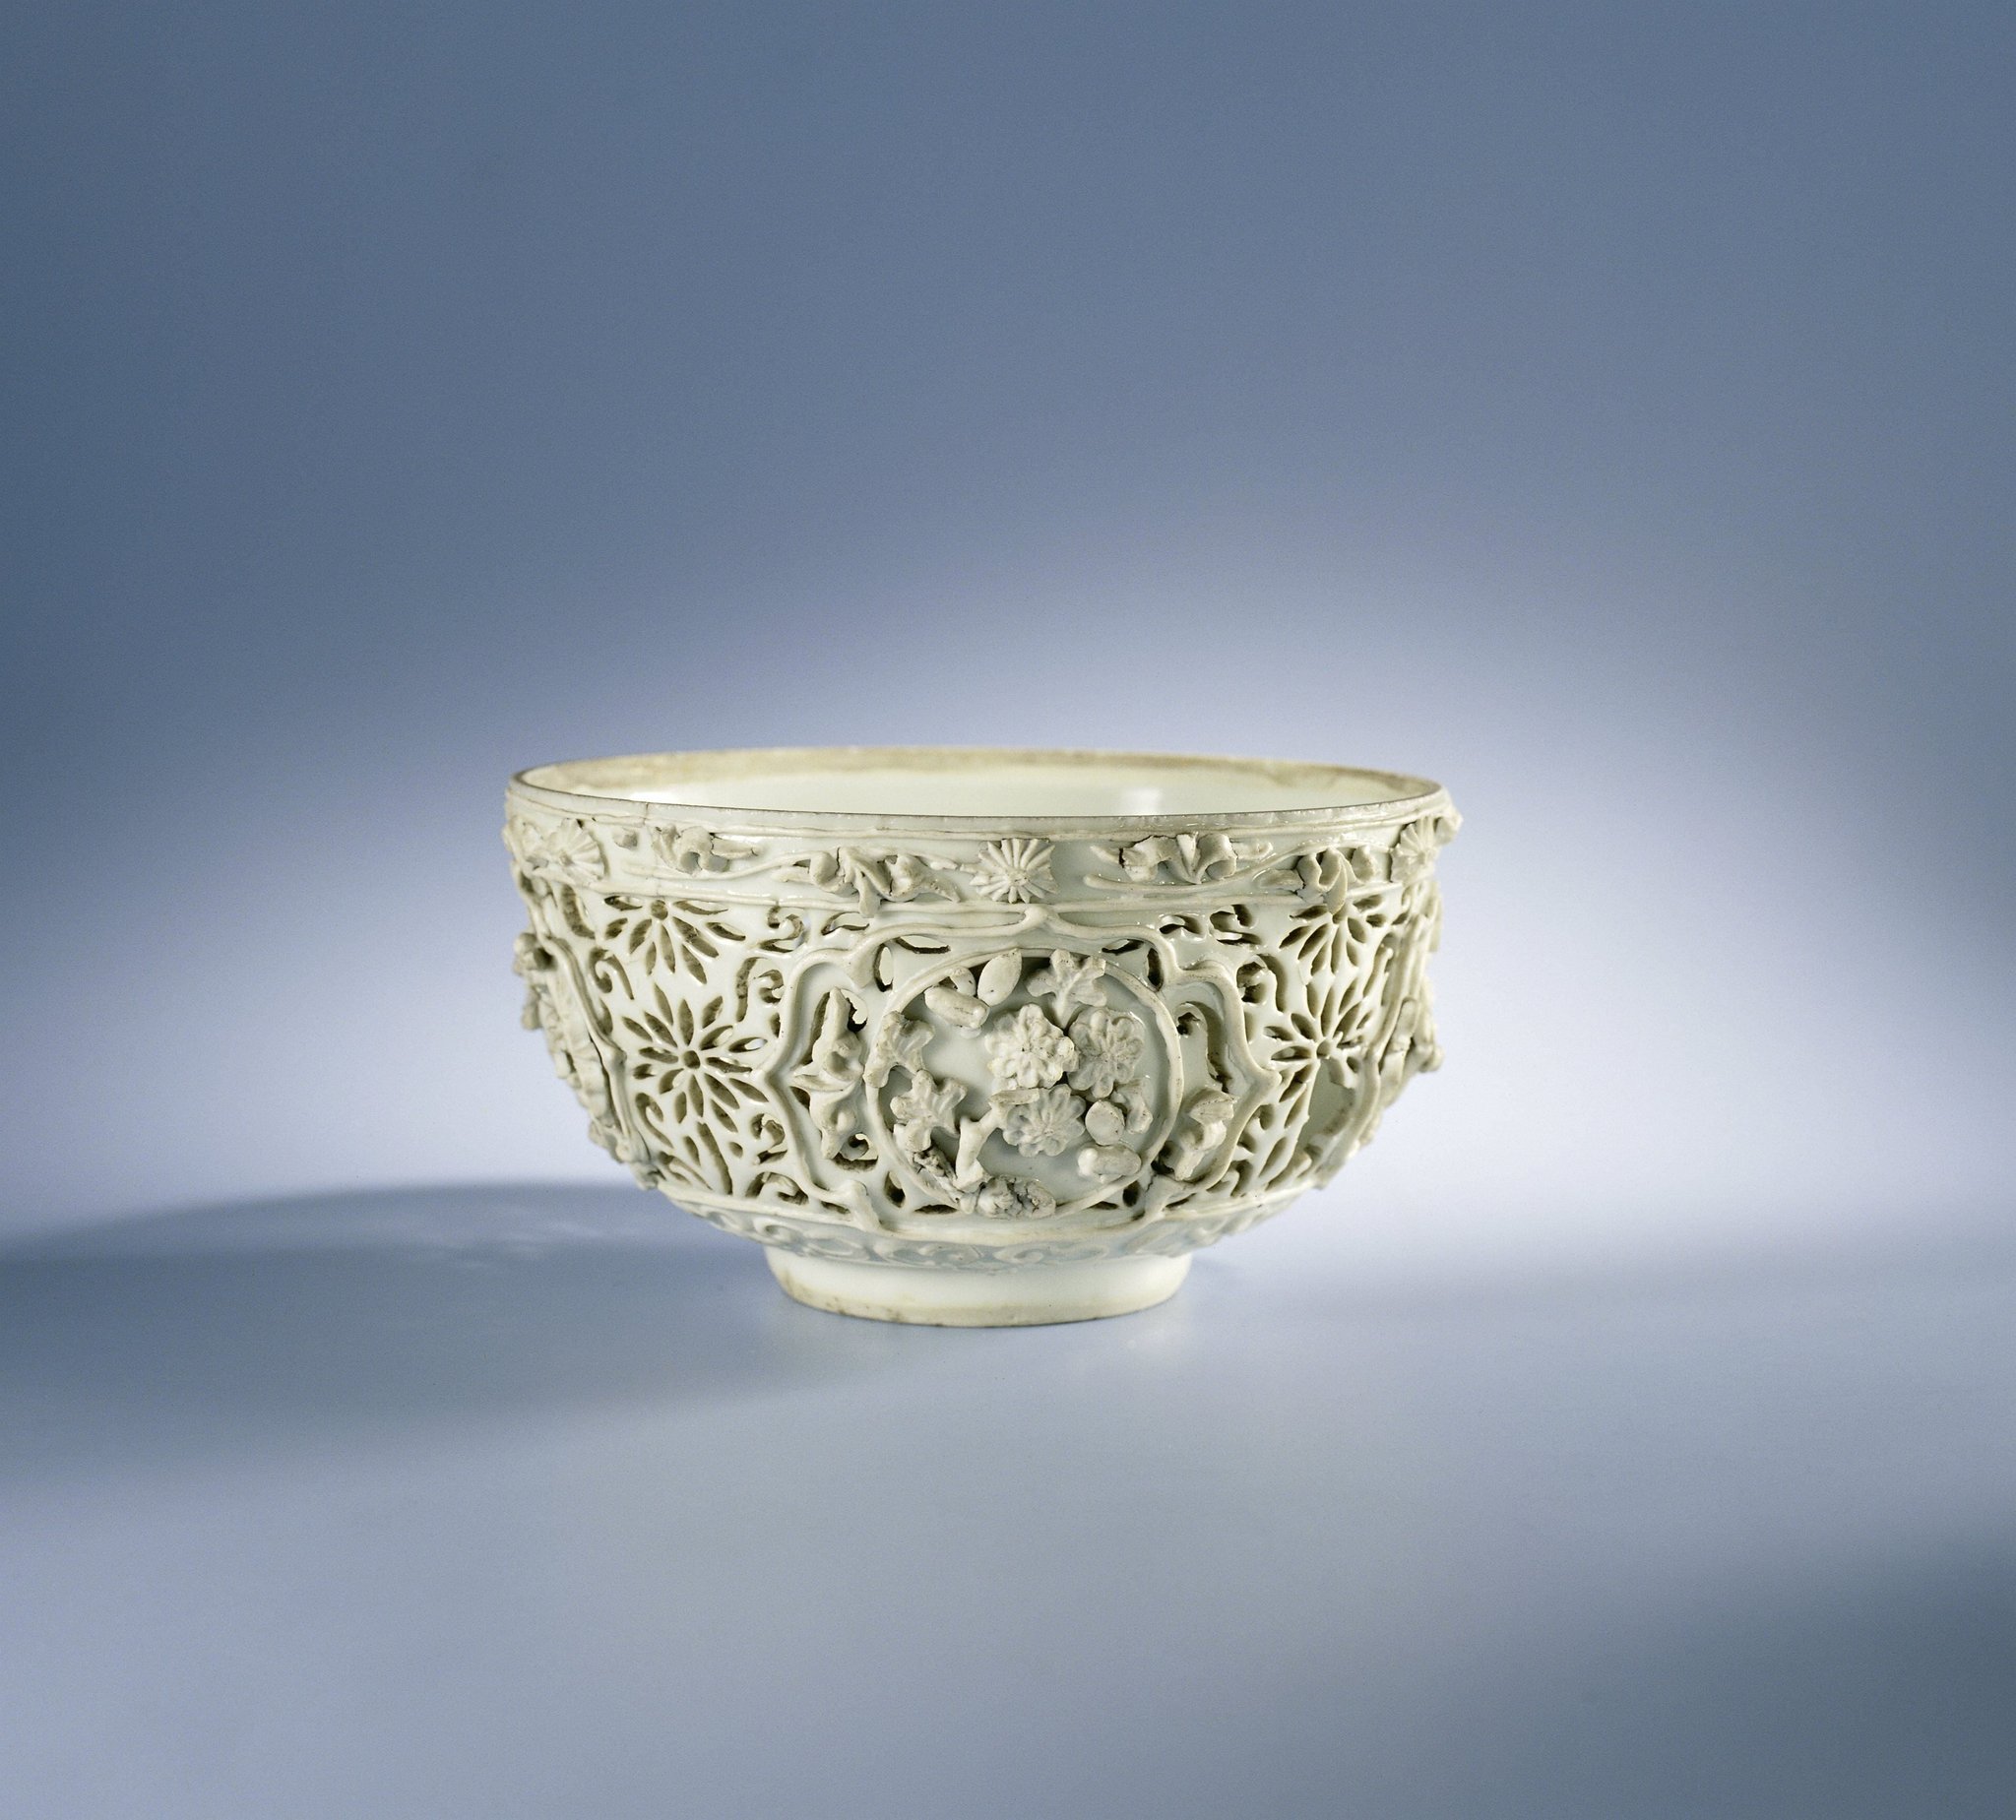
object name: bowl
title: Bowl with pierced sides and moulded flower sprays and floral scrolls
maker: Anonymous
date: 1600-1649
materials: glaze, porcelain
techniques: embroidery, firing, forming, turning, vitrification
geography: china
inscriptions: mark: ‘成 化 年 製 Chénghuà nián zhì’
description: Een wit geglazuurde kom op dikke platte voetring. De buitenzijde bevat vier medaillions met accoladevormige rand, die ieder zijn gesierd door bloemtakken, herten en vogels in hoogreliëf. De medaillons zijn geplaatst tegen een ajour fond van bloemmotieven. Langs de schuine onderrand een band met wolkenmotief en rondom de bovenrand een band van doorlopende bloemranken, beide uitgevoerd in hoogreliëf. Gemerkt op de bodem met het vier-karaktermerk Chenghua. De deksel ontbreekt.